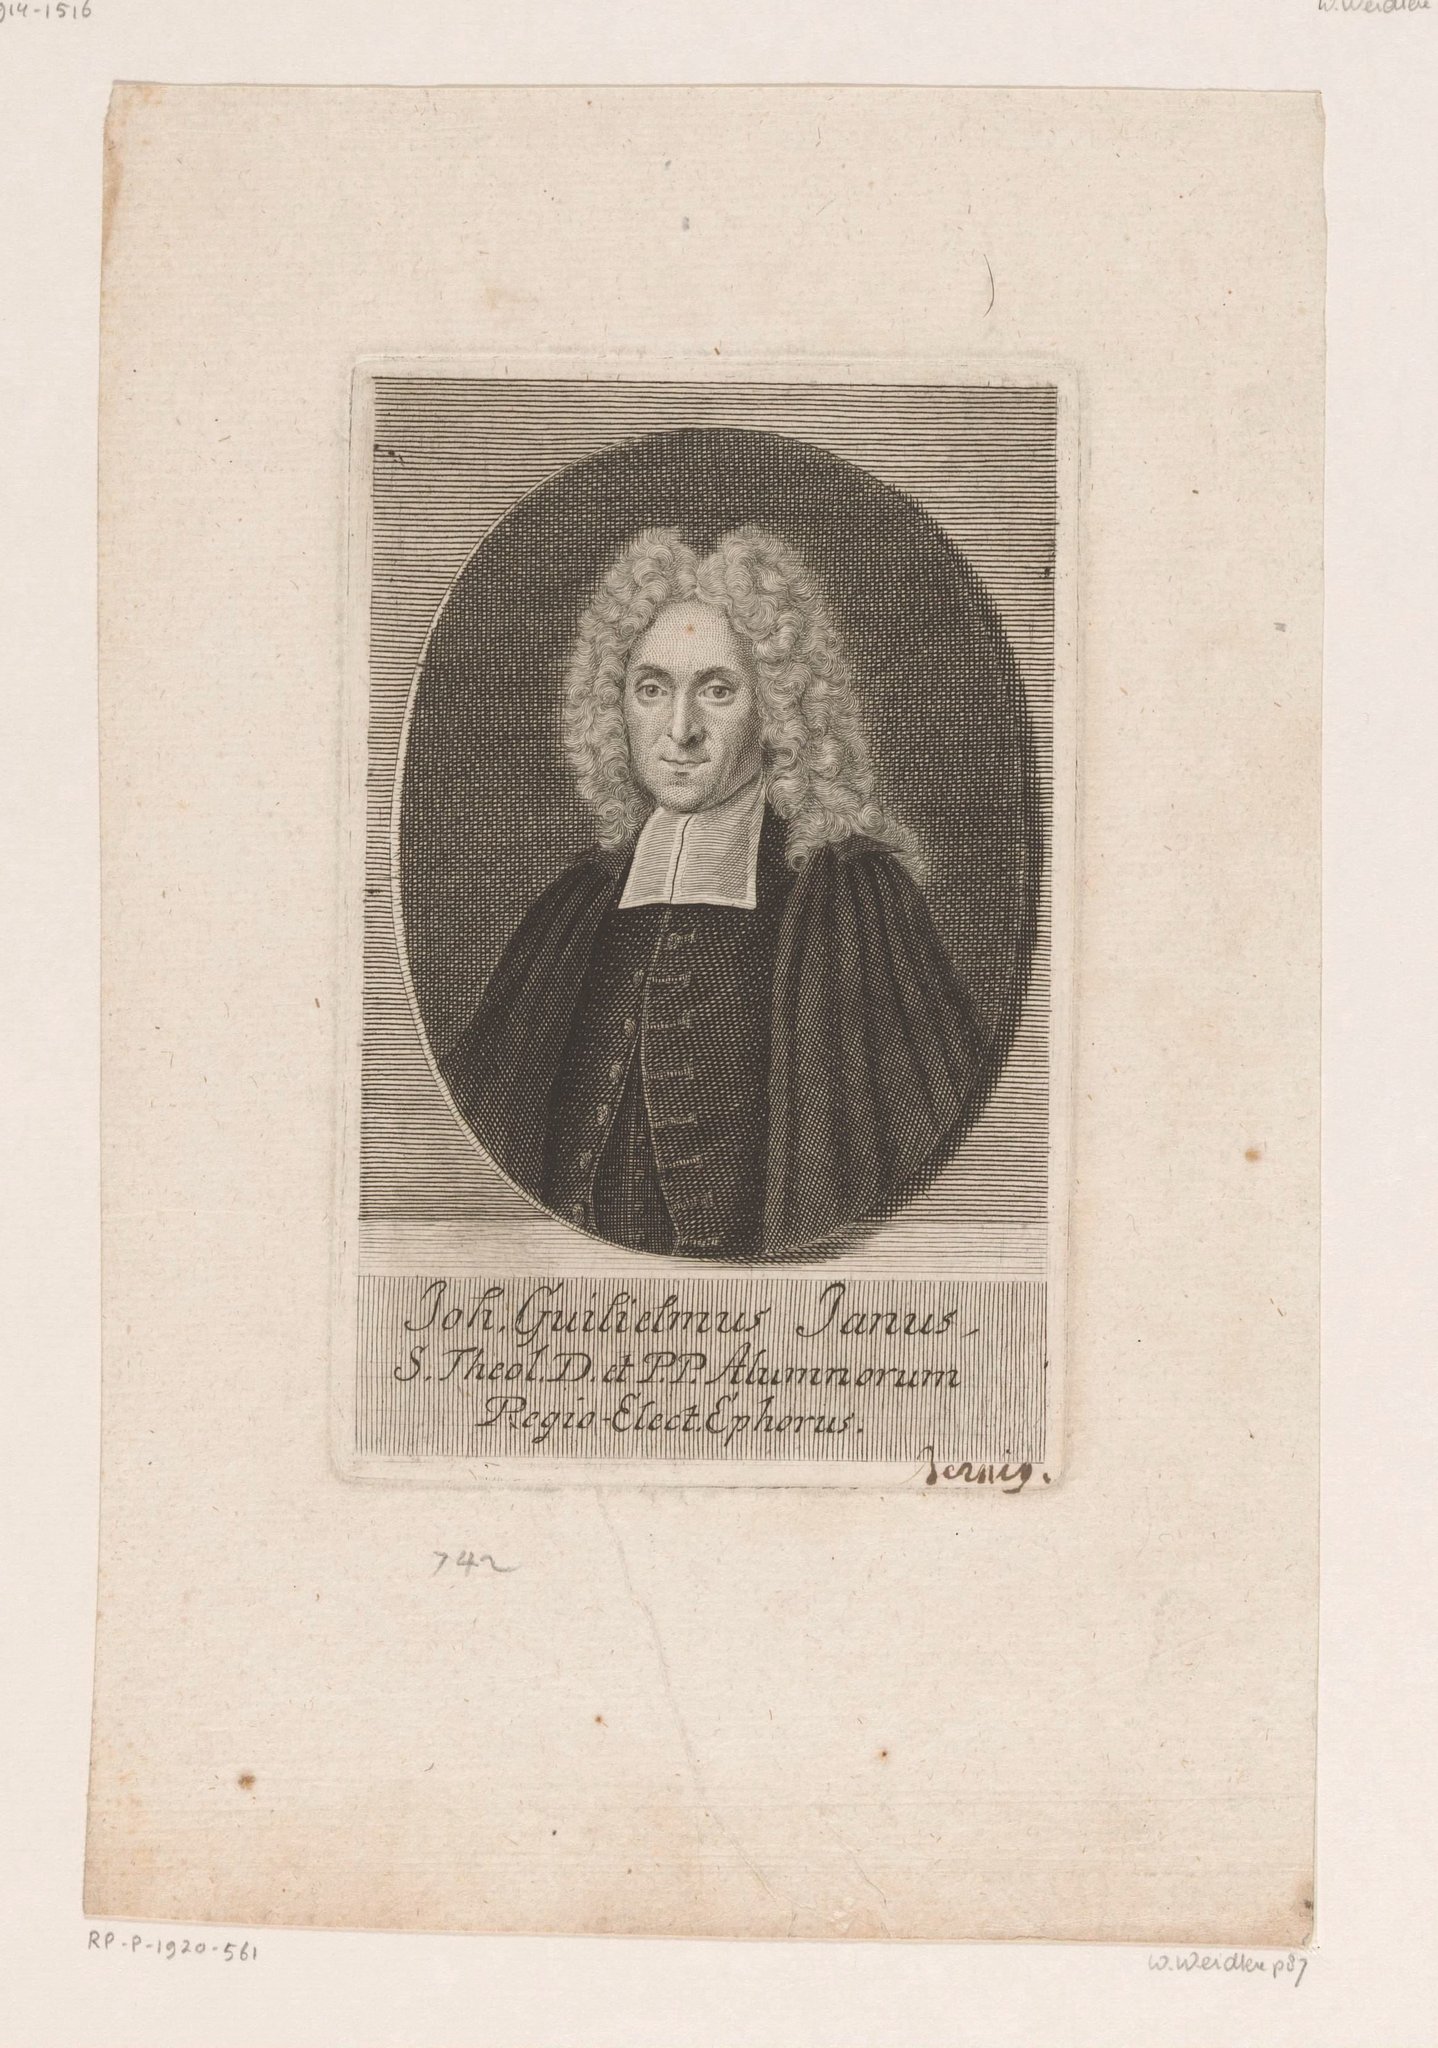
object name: print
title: Portret van Johann Wilhelm Jahn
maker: martin bernigeroth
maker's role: print maker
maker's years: 1670-1733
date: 1719-1733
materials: paper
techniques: engraving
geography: leipzig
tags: historical persons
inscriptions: collector's mark: Lugt 2228